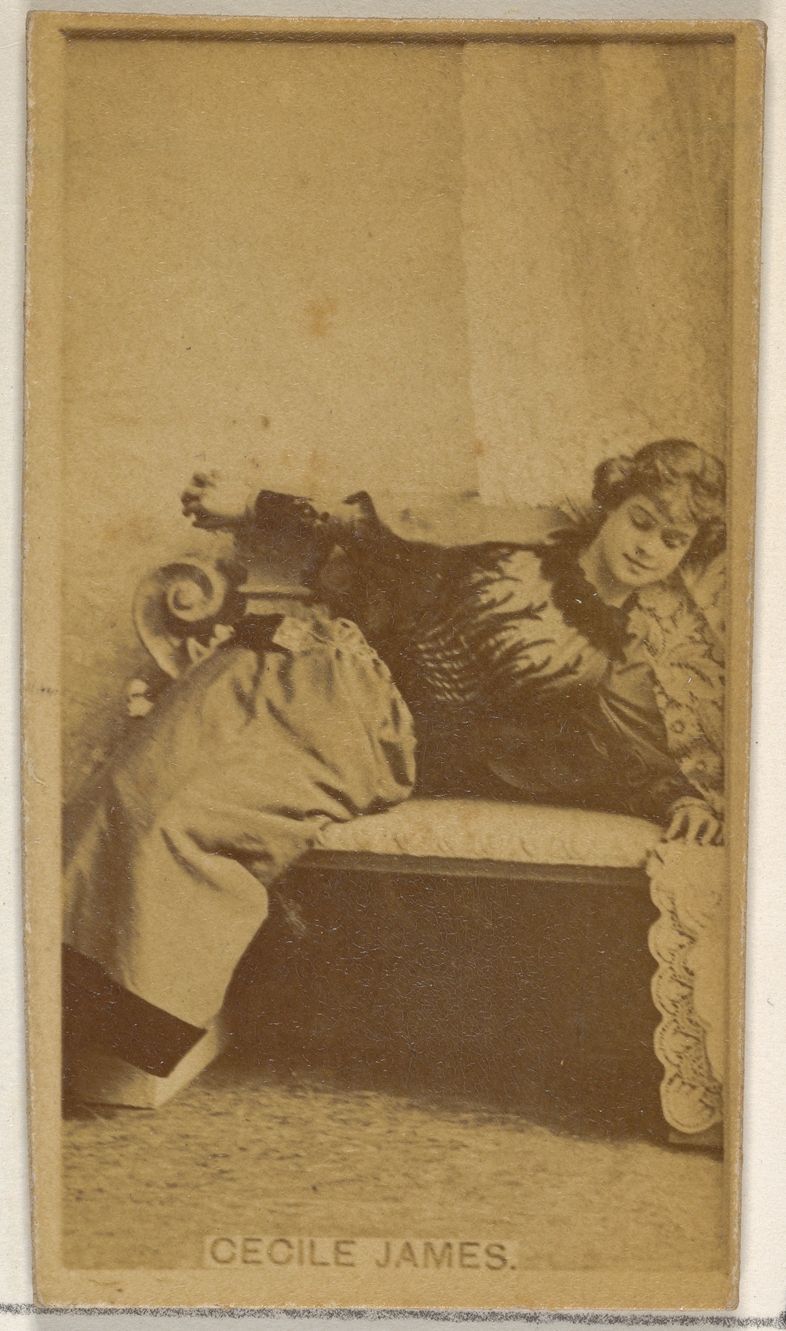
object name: photograph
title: Cecile James, from the Actors and Actresses series (N45, Type 8) for Virginia Brights Cigarettes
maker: allen & ginter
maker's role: publisher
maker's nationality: american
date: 1888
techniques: albumen silver print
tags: portraits,women,actresses